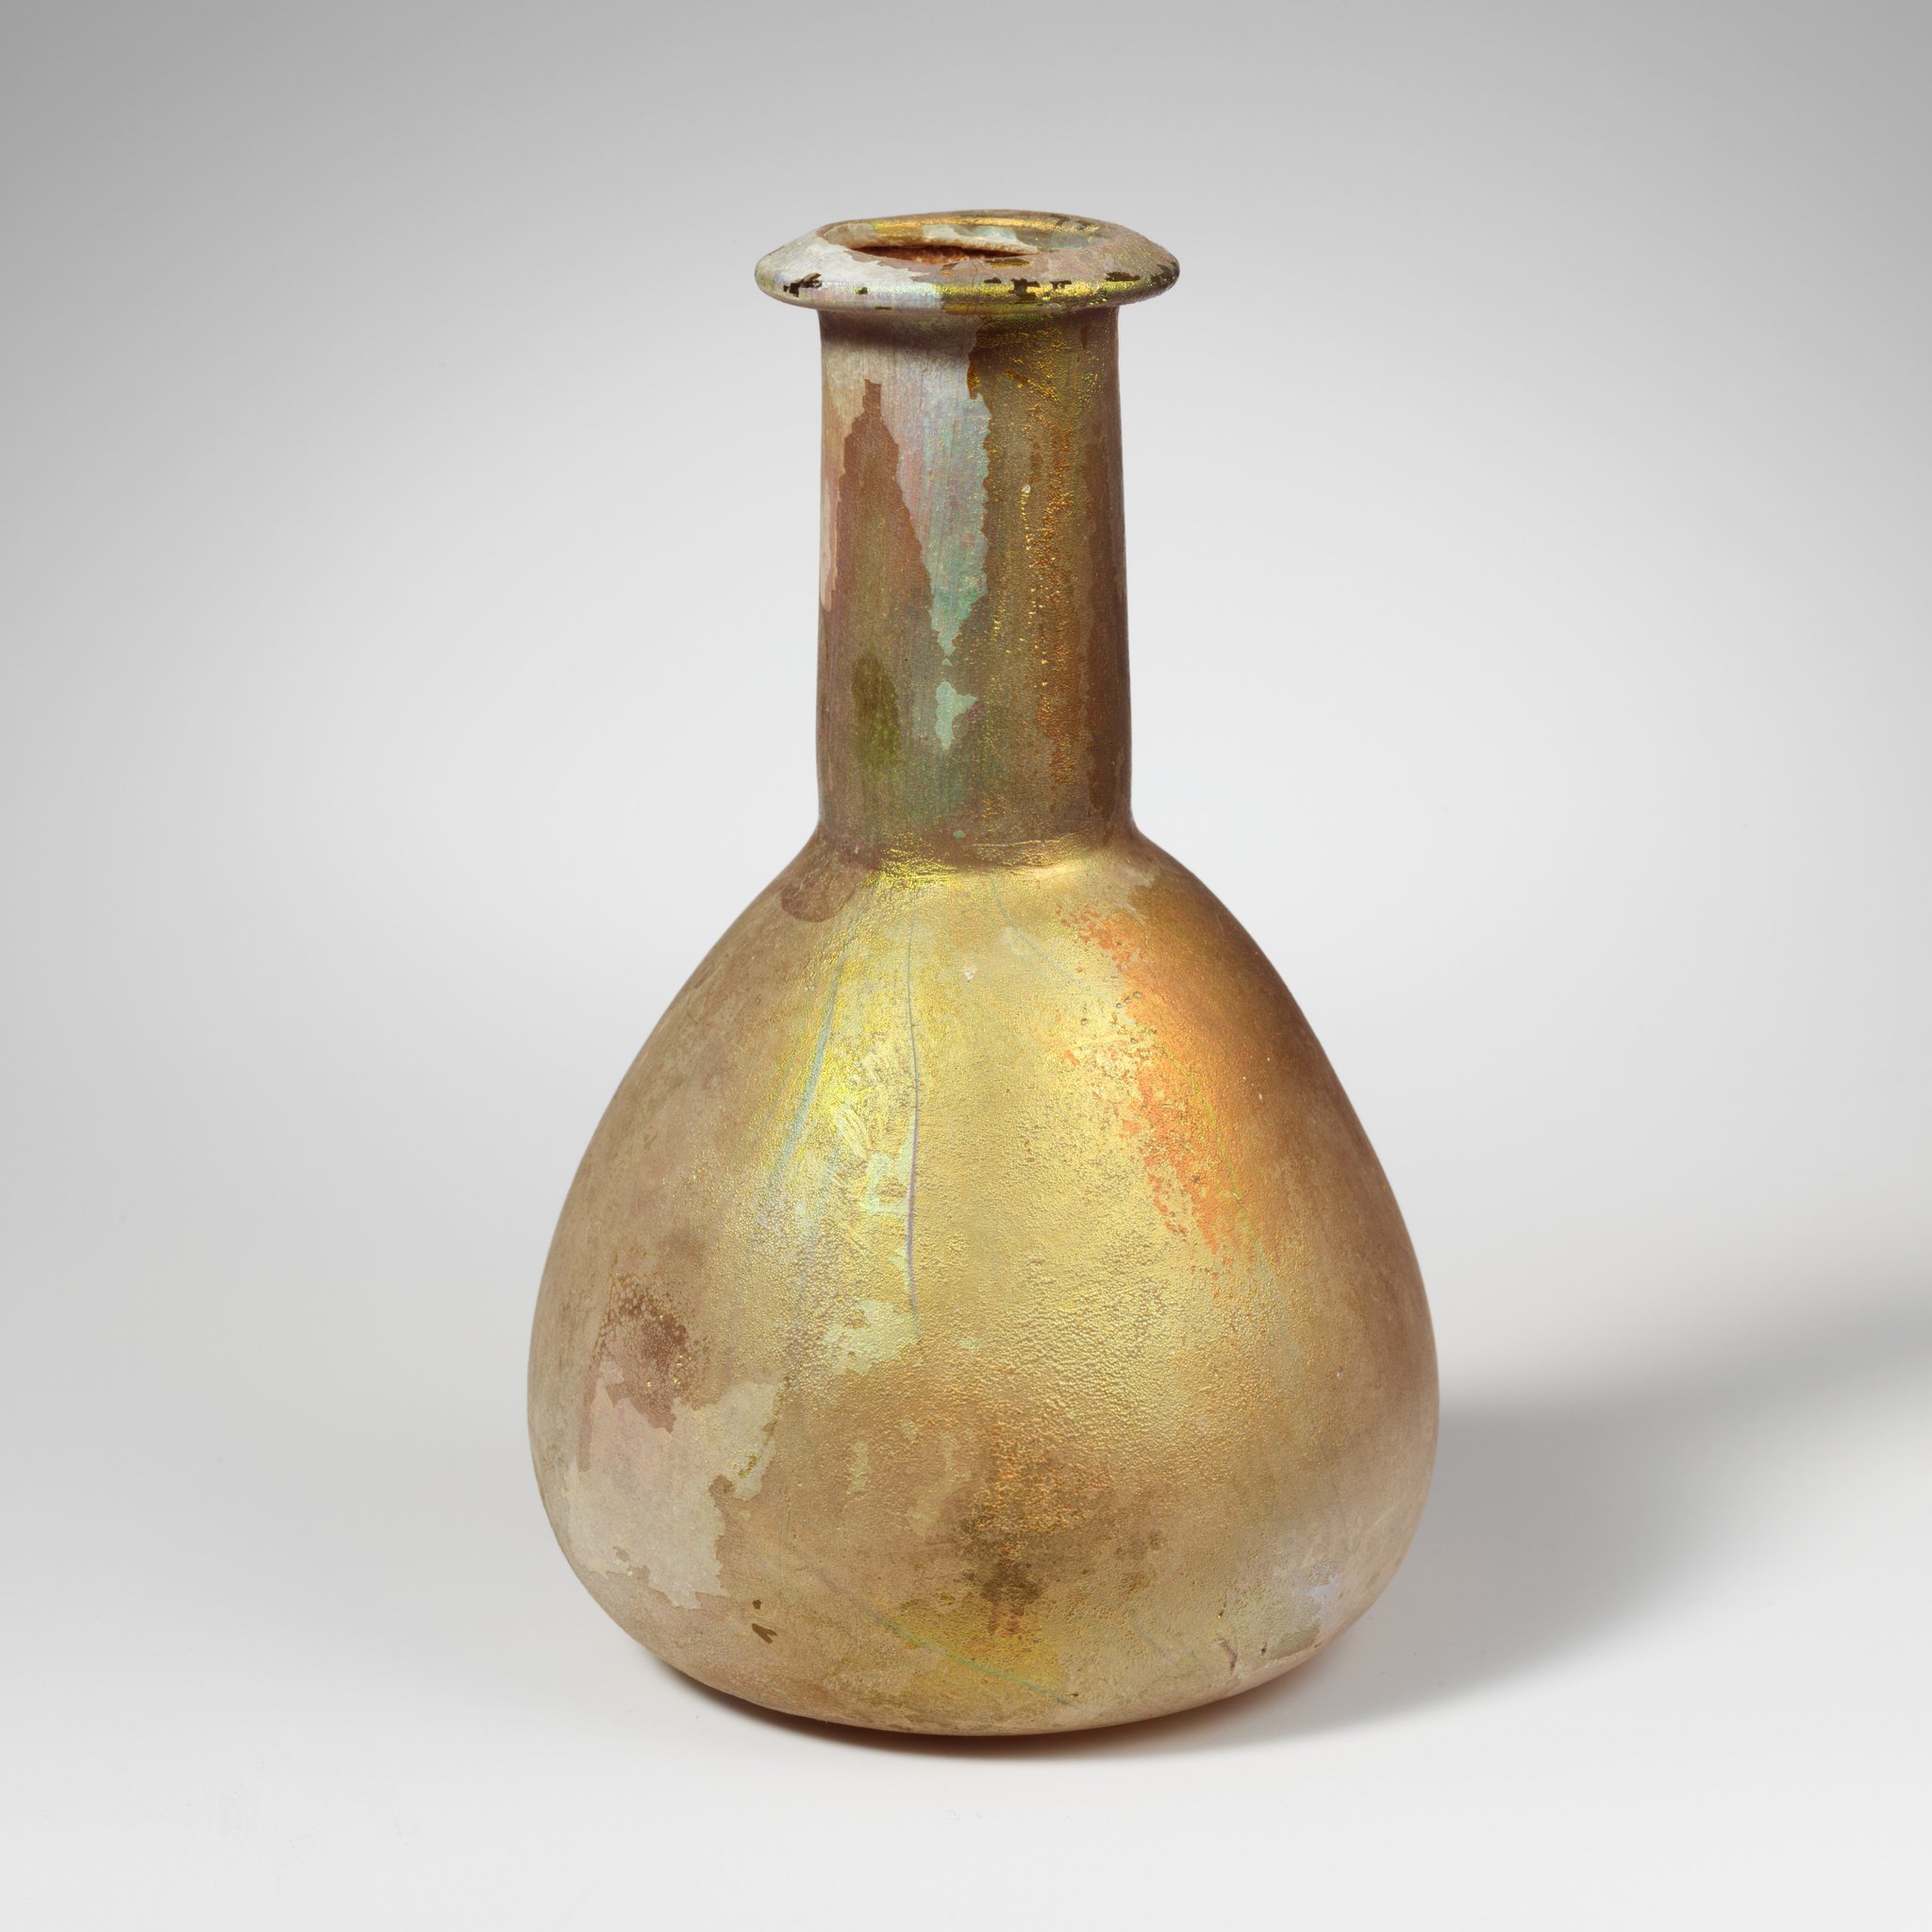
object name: perfume bottle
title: Glass perfume bottle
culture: roman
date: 1-200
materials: glass